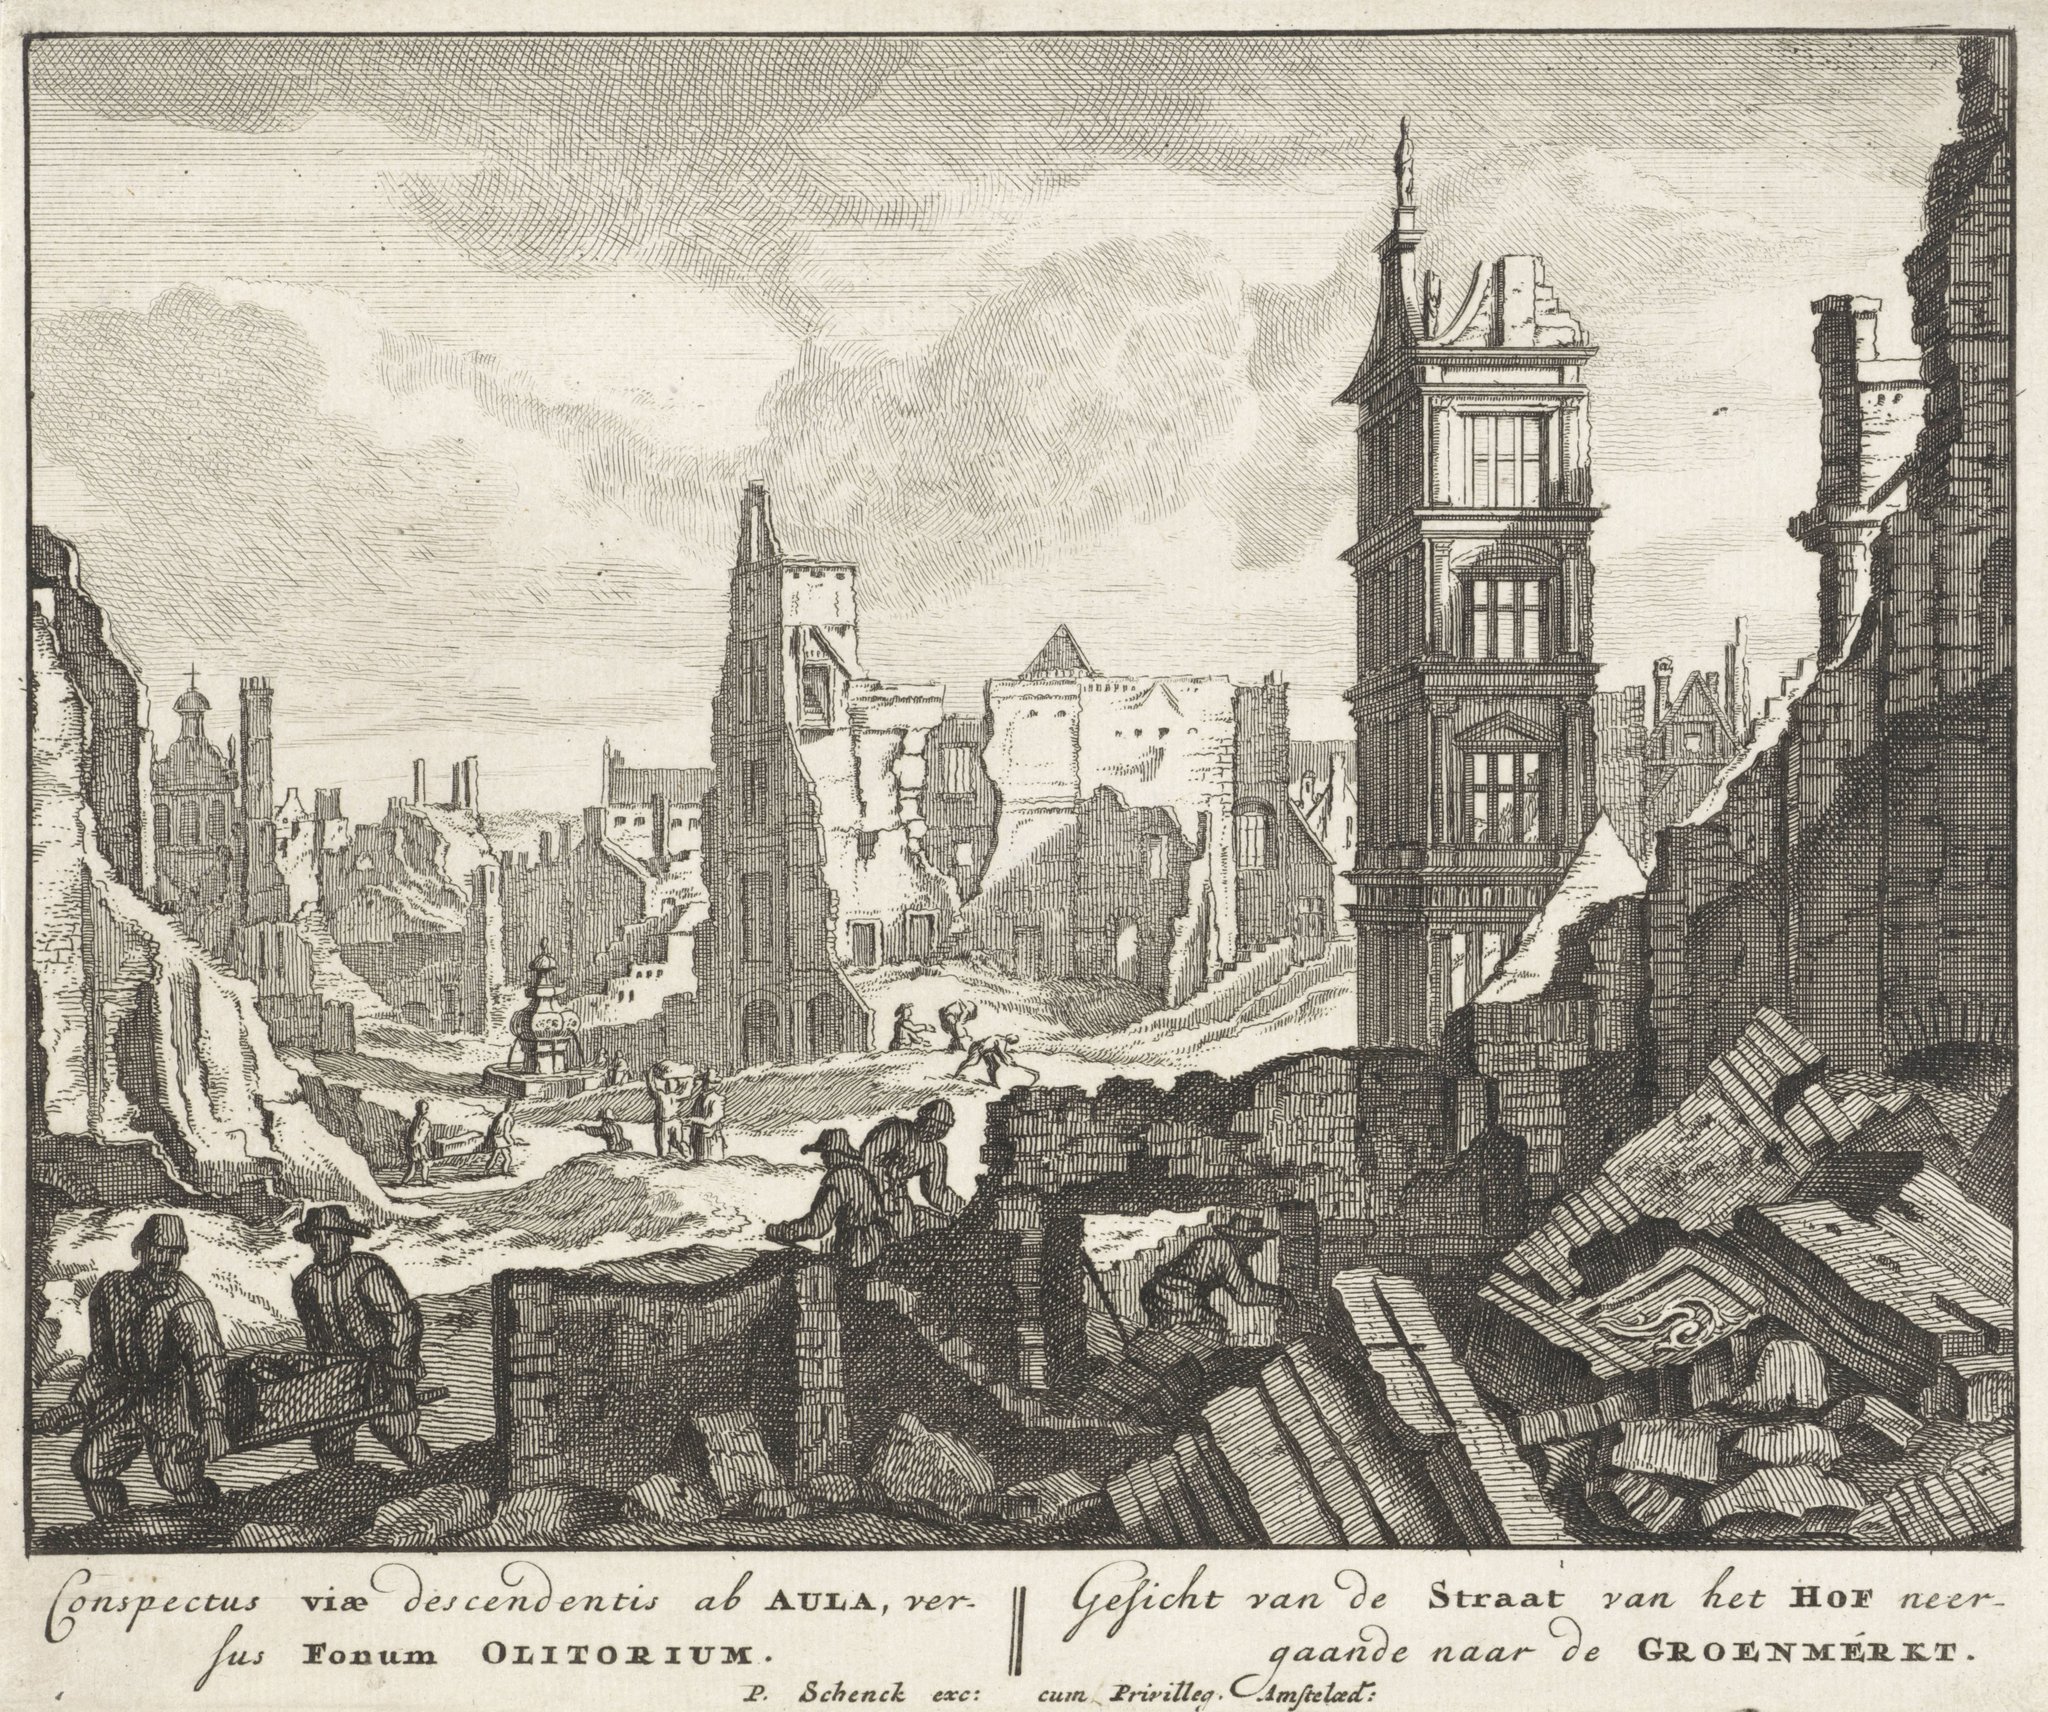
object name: print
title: Ruïnes bij de Grasmarkt te Brussel, 1695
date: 1695-1711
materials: paper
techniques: etching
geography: amsterdam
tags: devastated, ruined place or city (~ warfare), brussels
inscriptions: collector's mark: Lugt 2233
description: De ruïnes bij de Grasmarkt te Brussel na het bombardement door de Fransen, 13-15 augustus 1695.